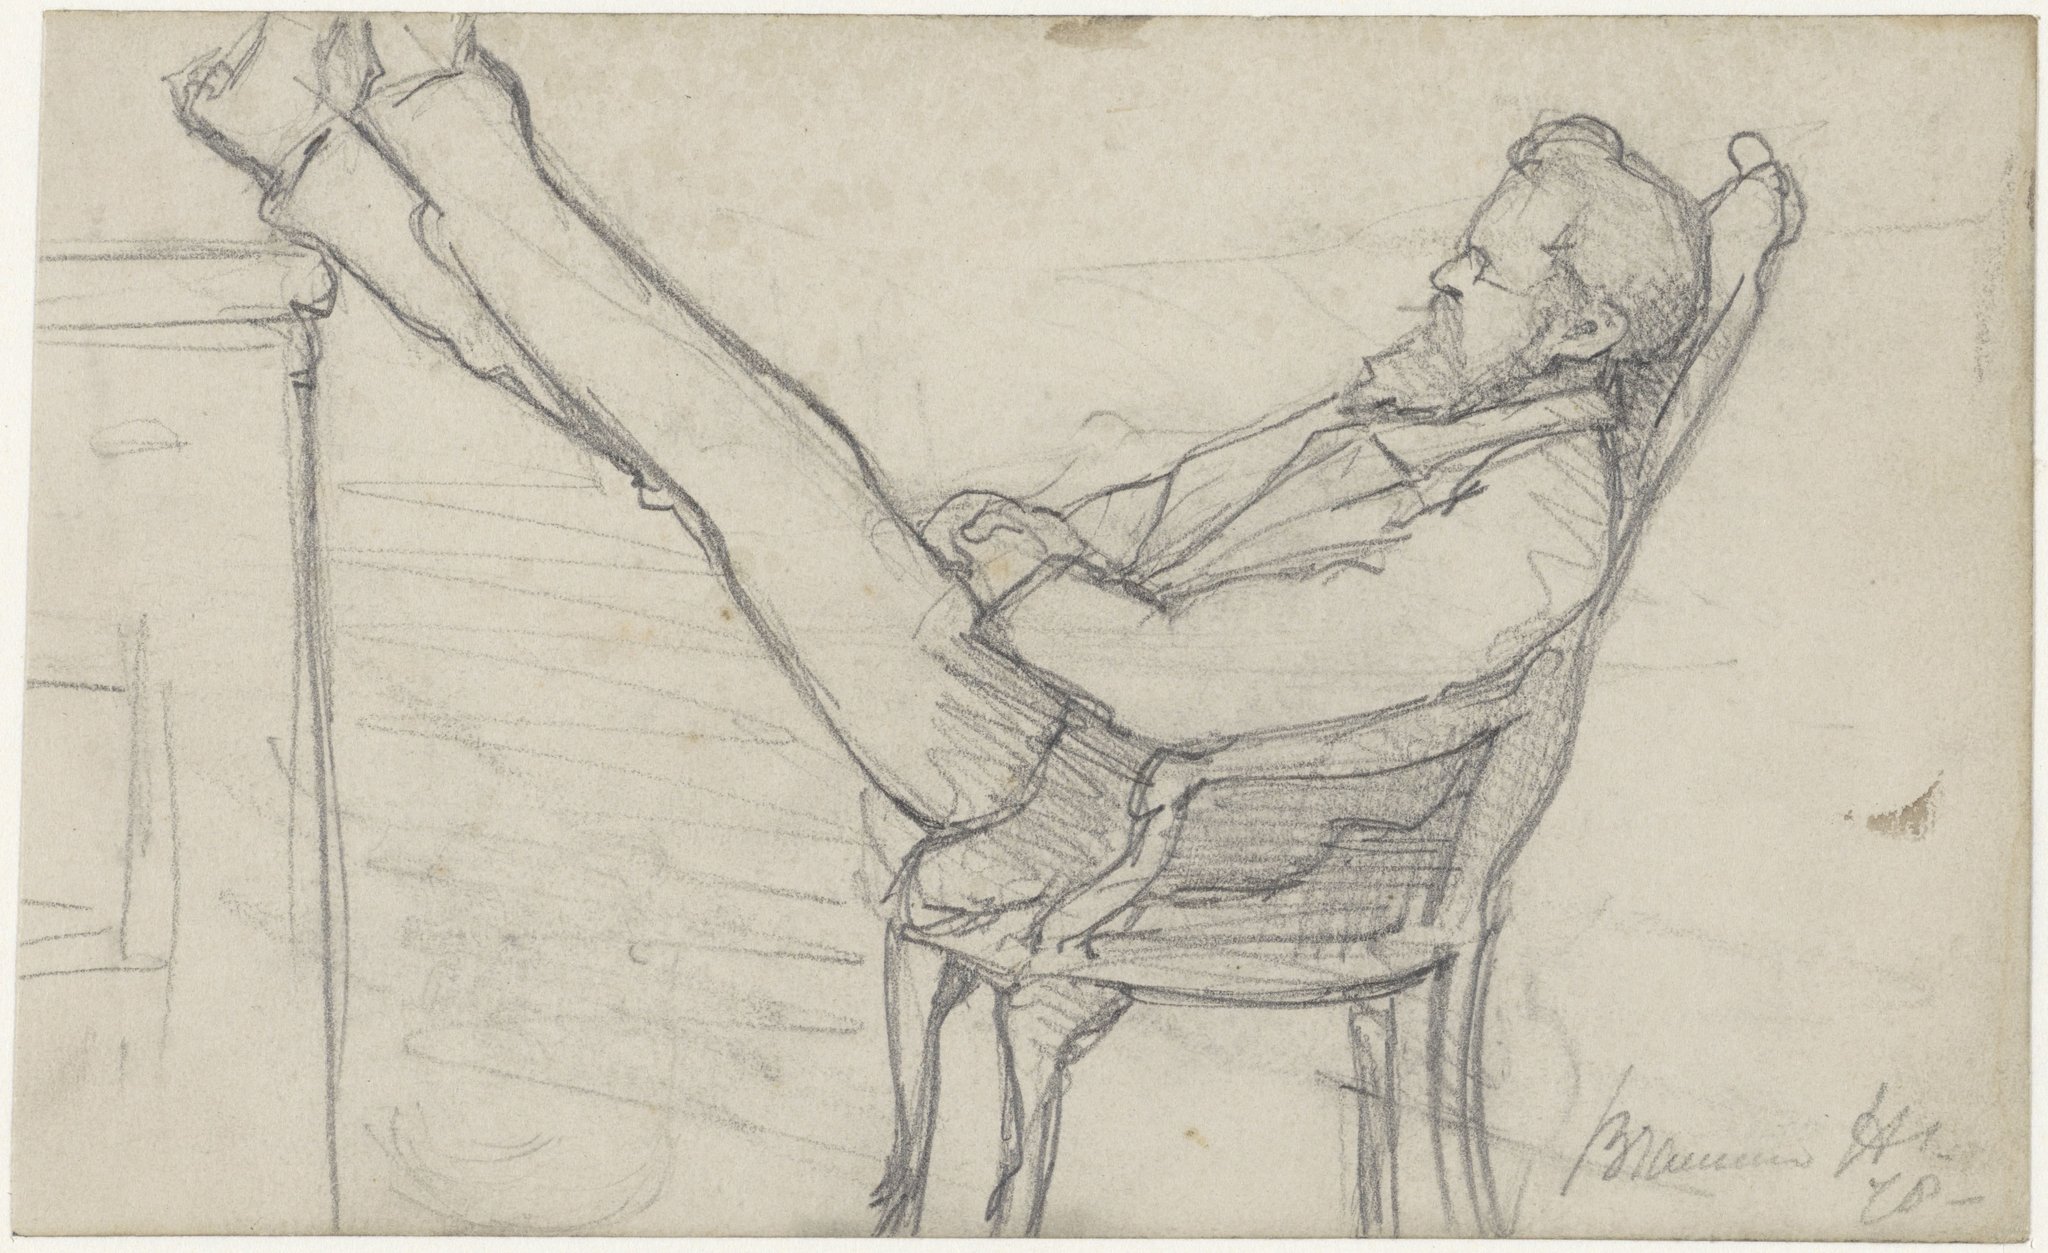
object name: drawing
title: Victor de Stuers (?) zittend met zijn benen omhoog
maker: a.a.l. de grammont-hubrecht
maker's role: draughtsman, painter, print maker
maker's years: 1855-1913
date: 1865-1913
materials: paper, pencil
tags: maastricht, the hague, print maker, draughtsman, jonkheer victor eugène louis de stuers, historical persons